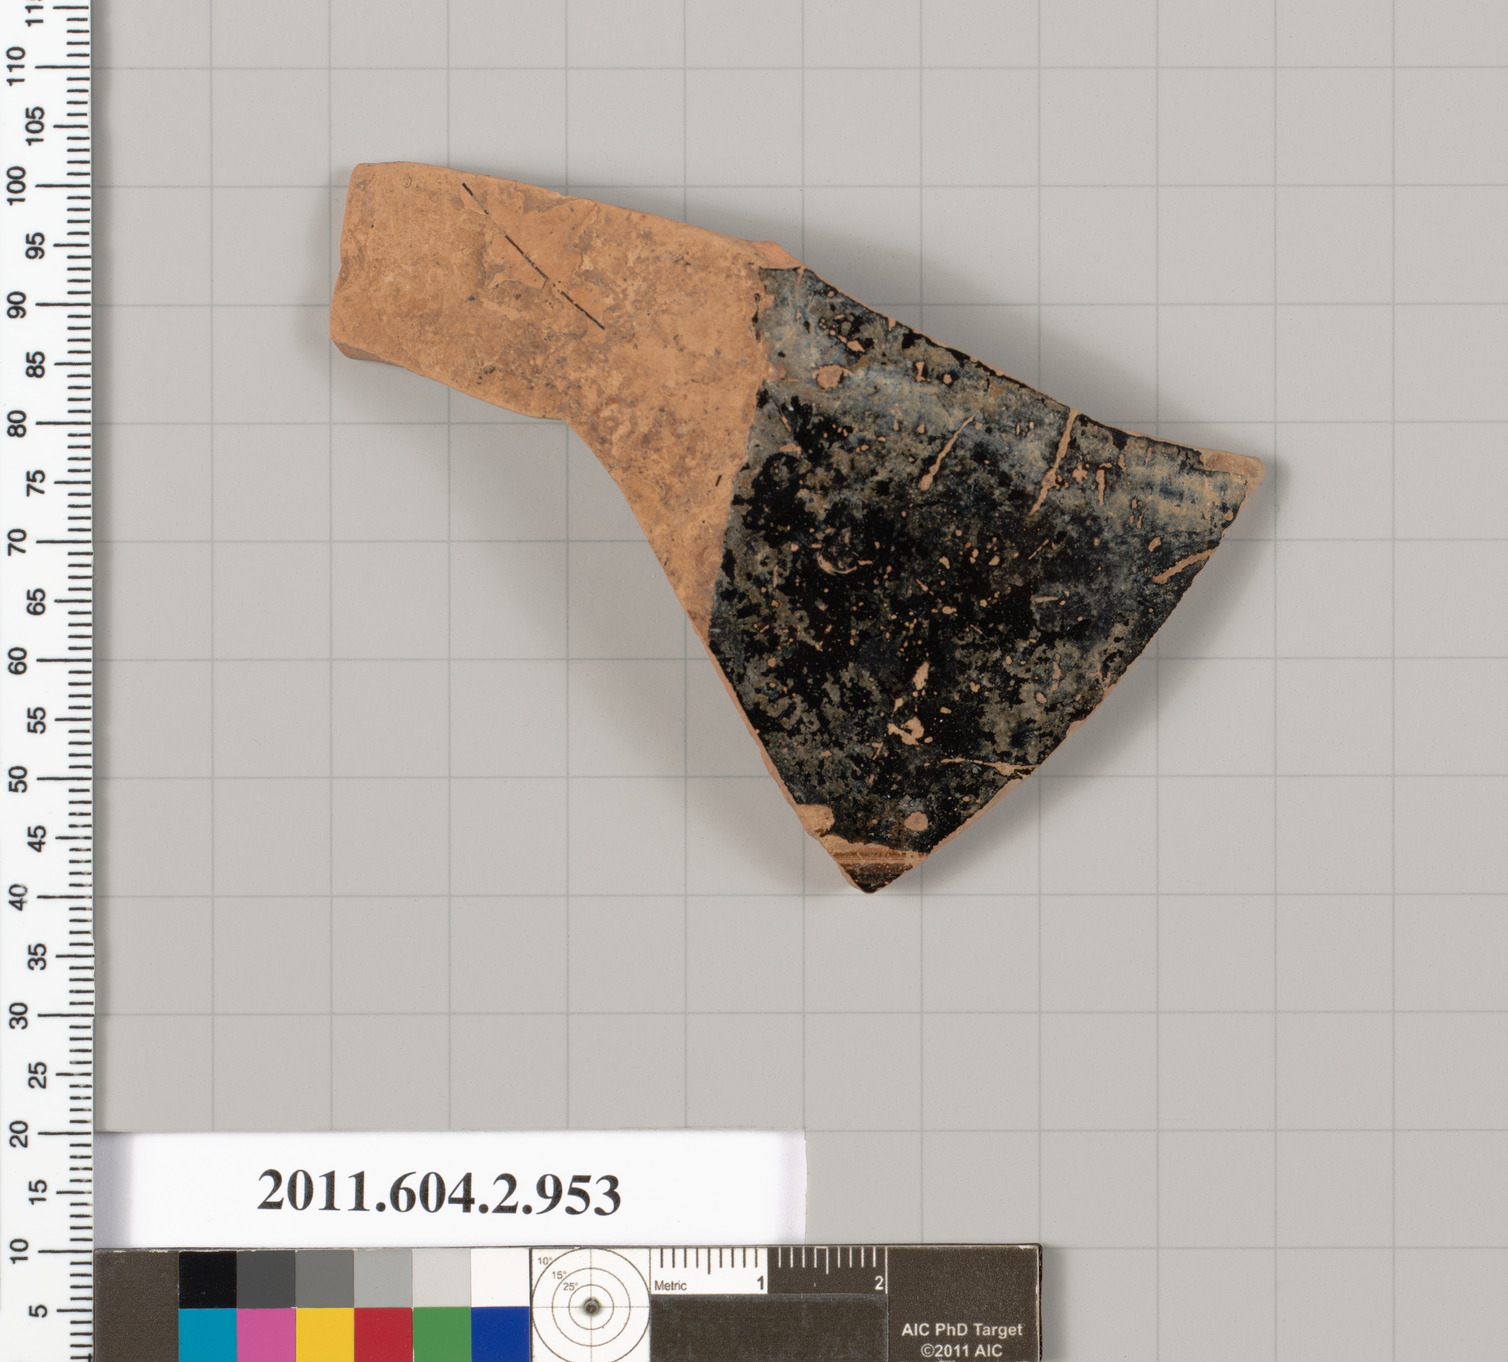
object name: oinochoe fragment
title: Terracotta fragment of an oinochoe (jug)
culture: greek, attic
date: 467-435 BCE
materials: terracotta